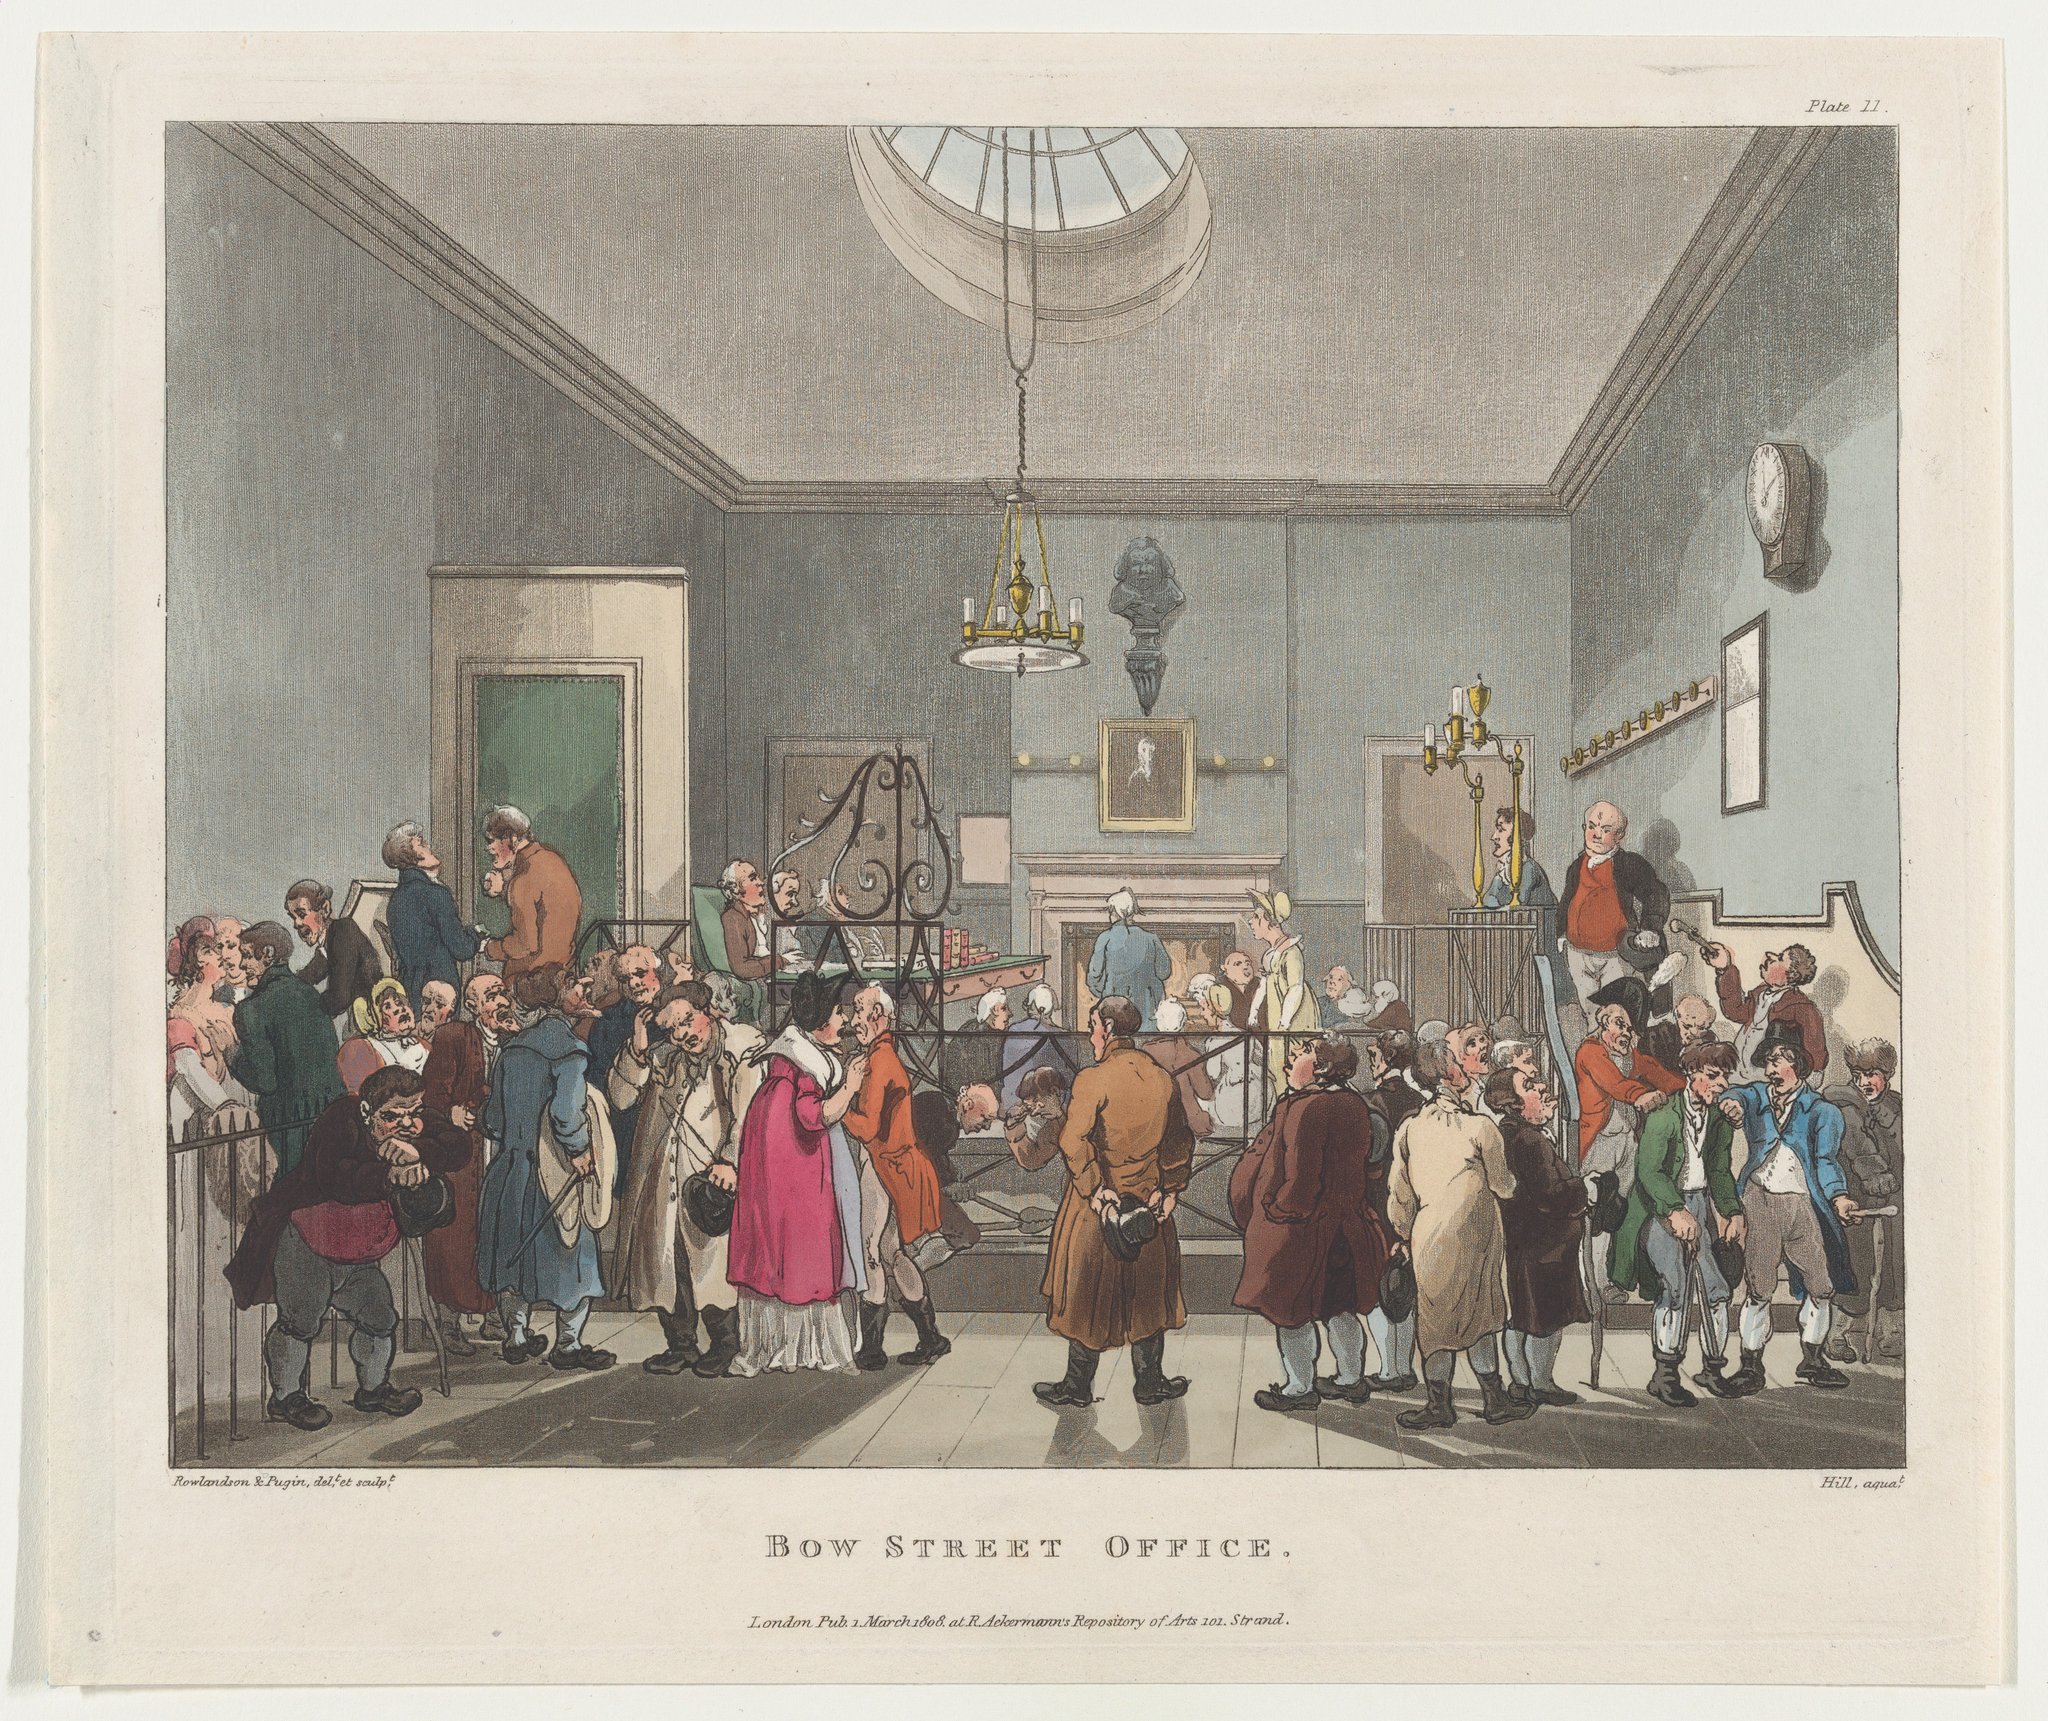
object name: print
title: Bow Street Office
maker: thomas rowlandson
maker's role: artist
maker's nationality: british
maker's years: 1757-1827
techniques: aquatint, etching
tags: men,women,crowd